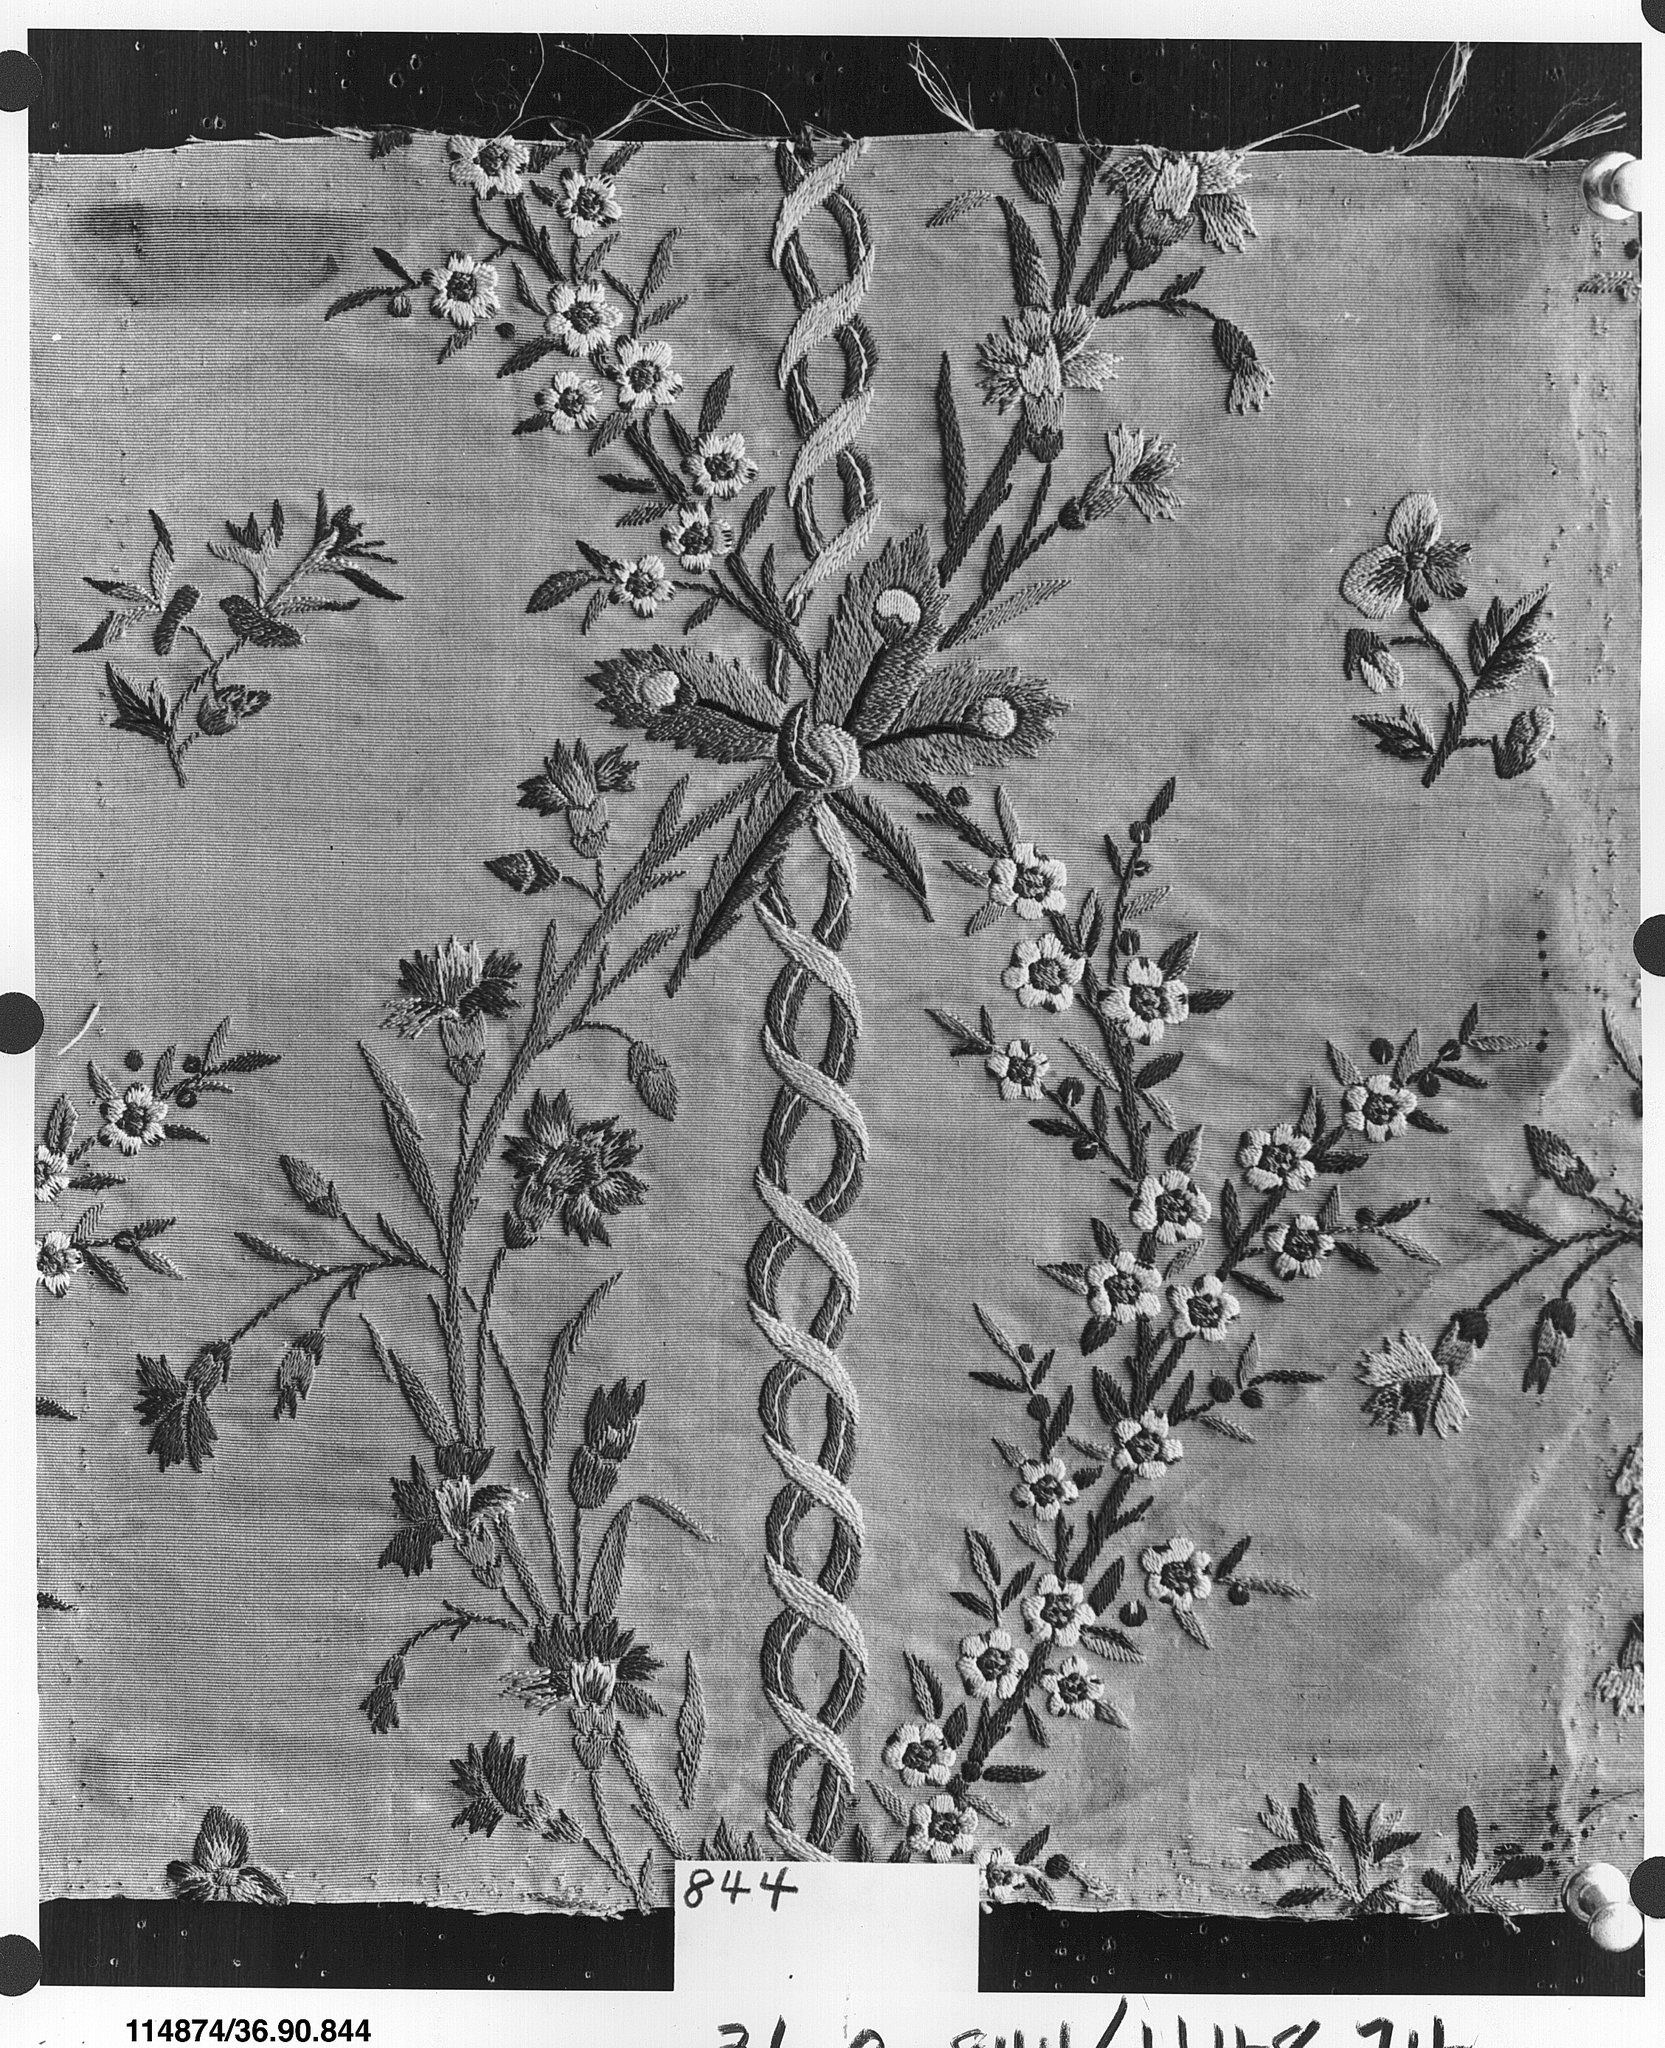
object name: piece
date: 1701-1800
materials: silk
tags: flowers,leaves